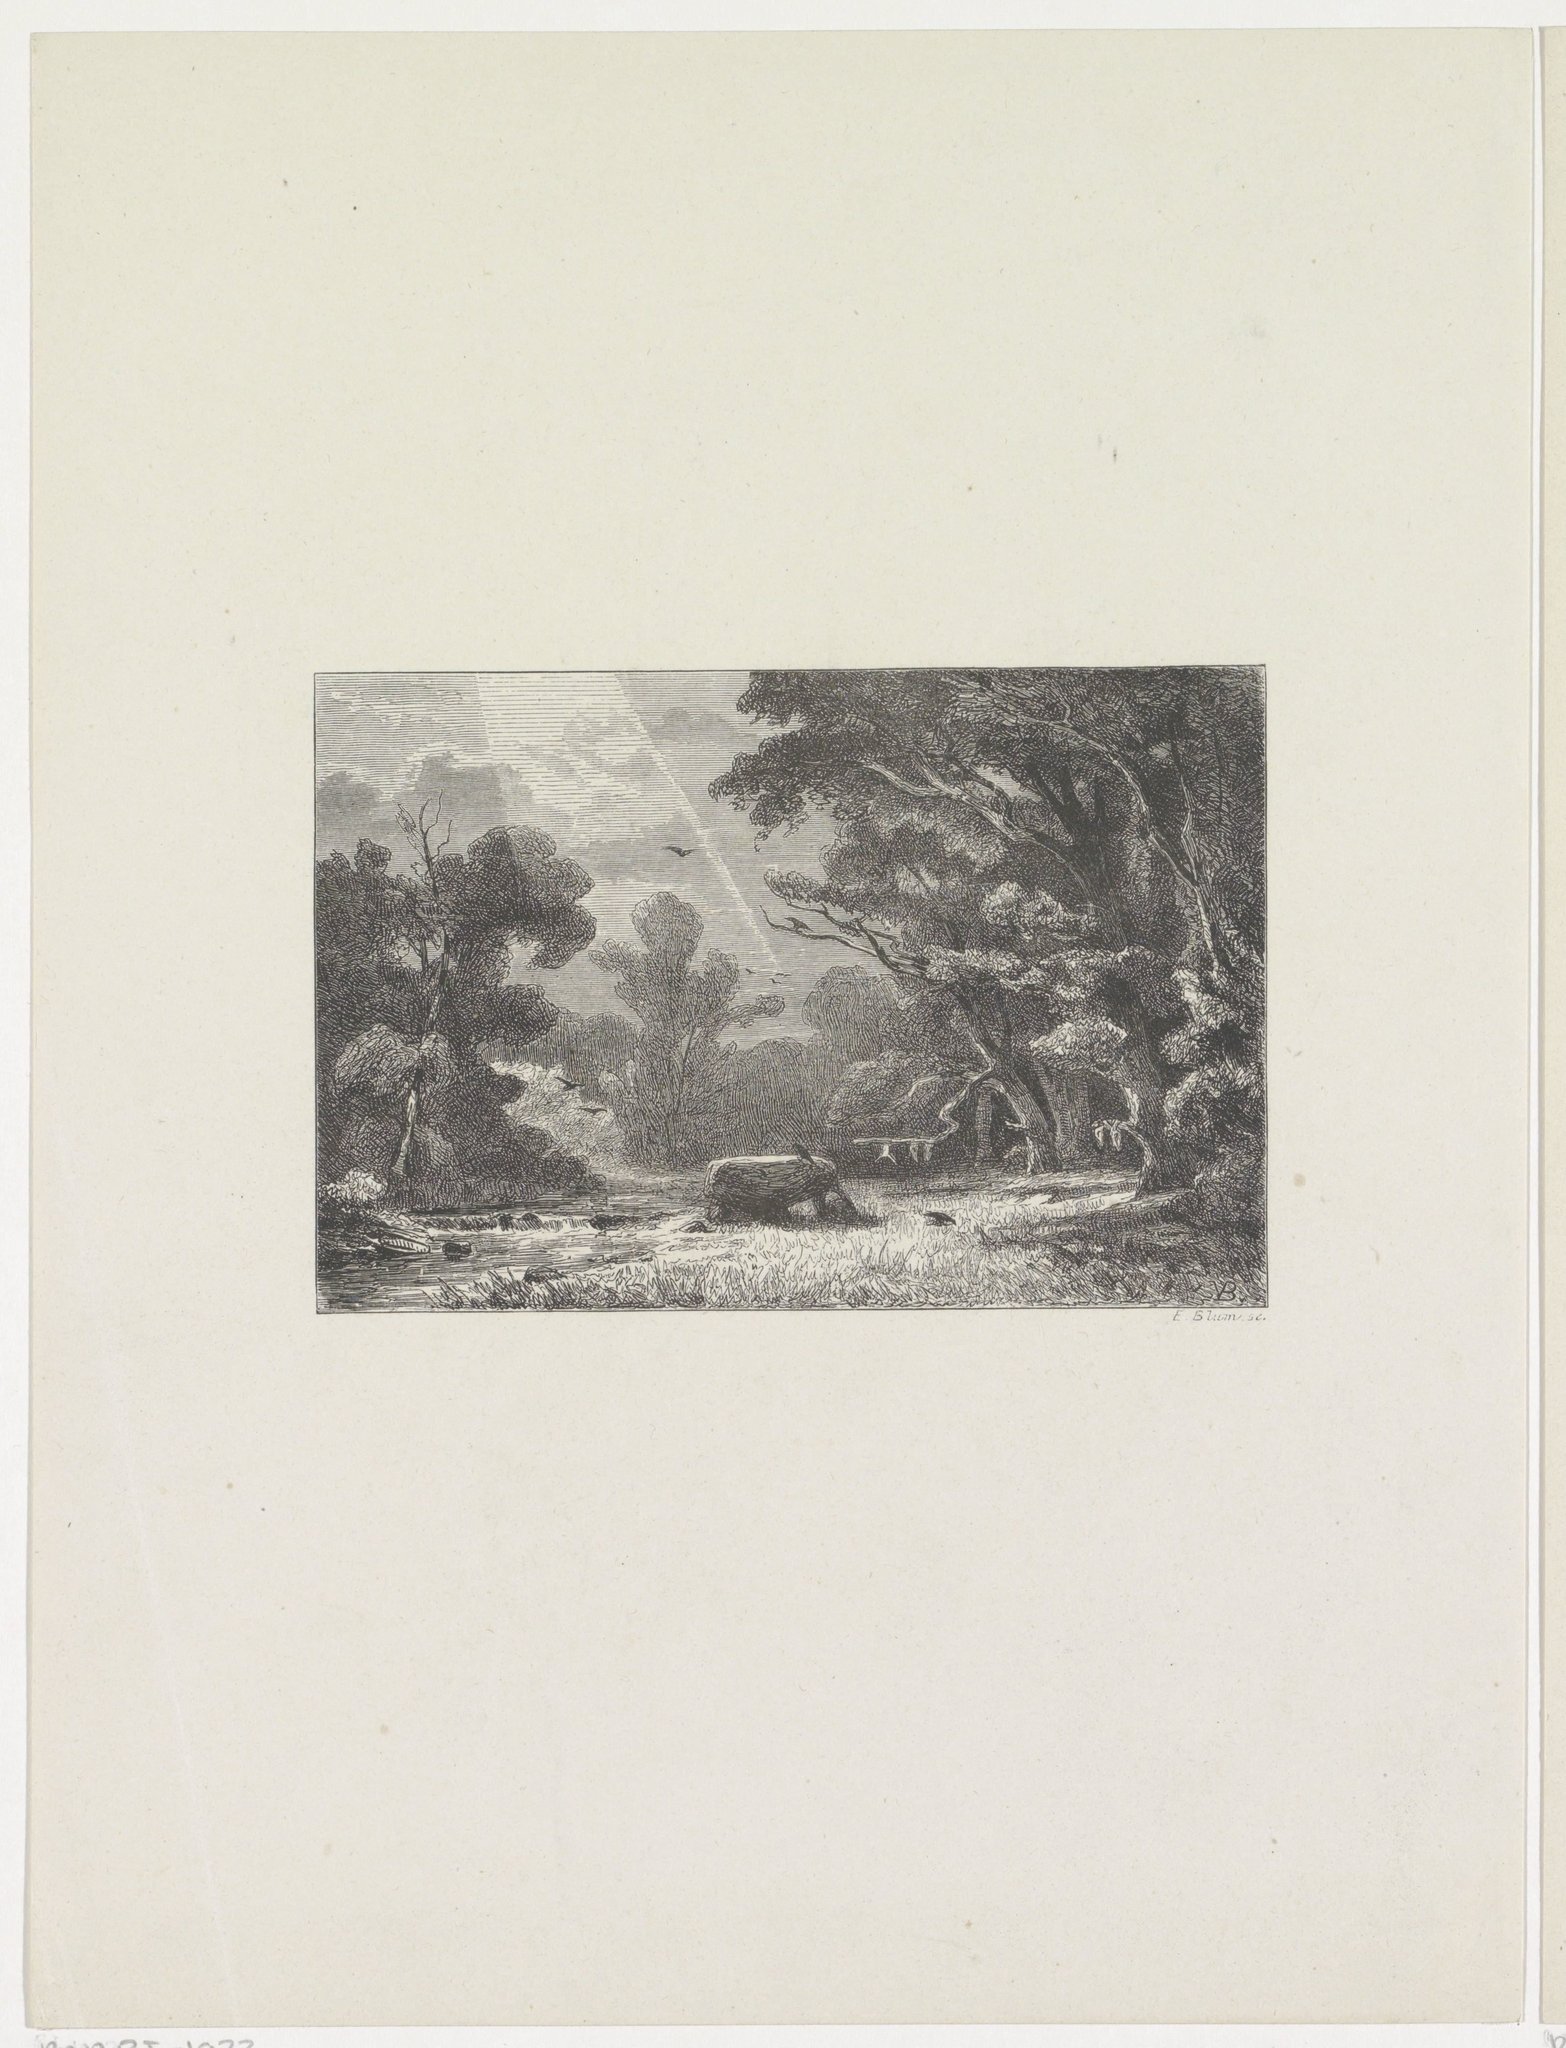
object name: print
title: Beekje met vogels langs een open veld bij een bos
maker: e. blum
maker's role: print maker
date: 1800-1899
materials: paper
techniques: engraving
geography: netherlands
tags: birds, forest, wood, brook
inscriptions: collector's mark: Lugt 2228